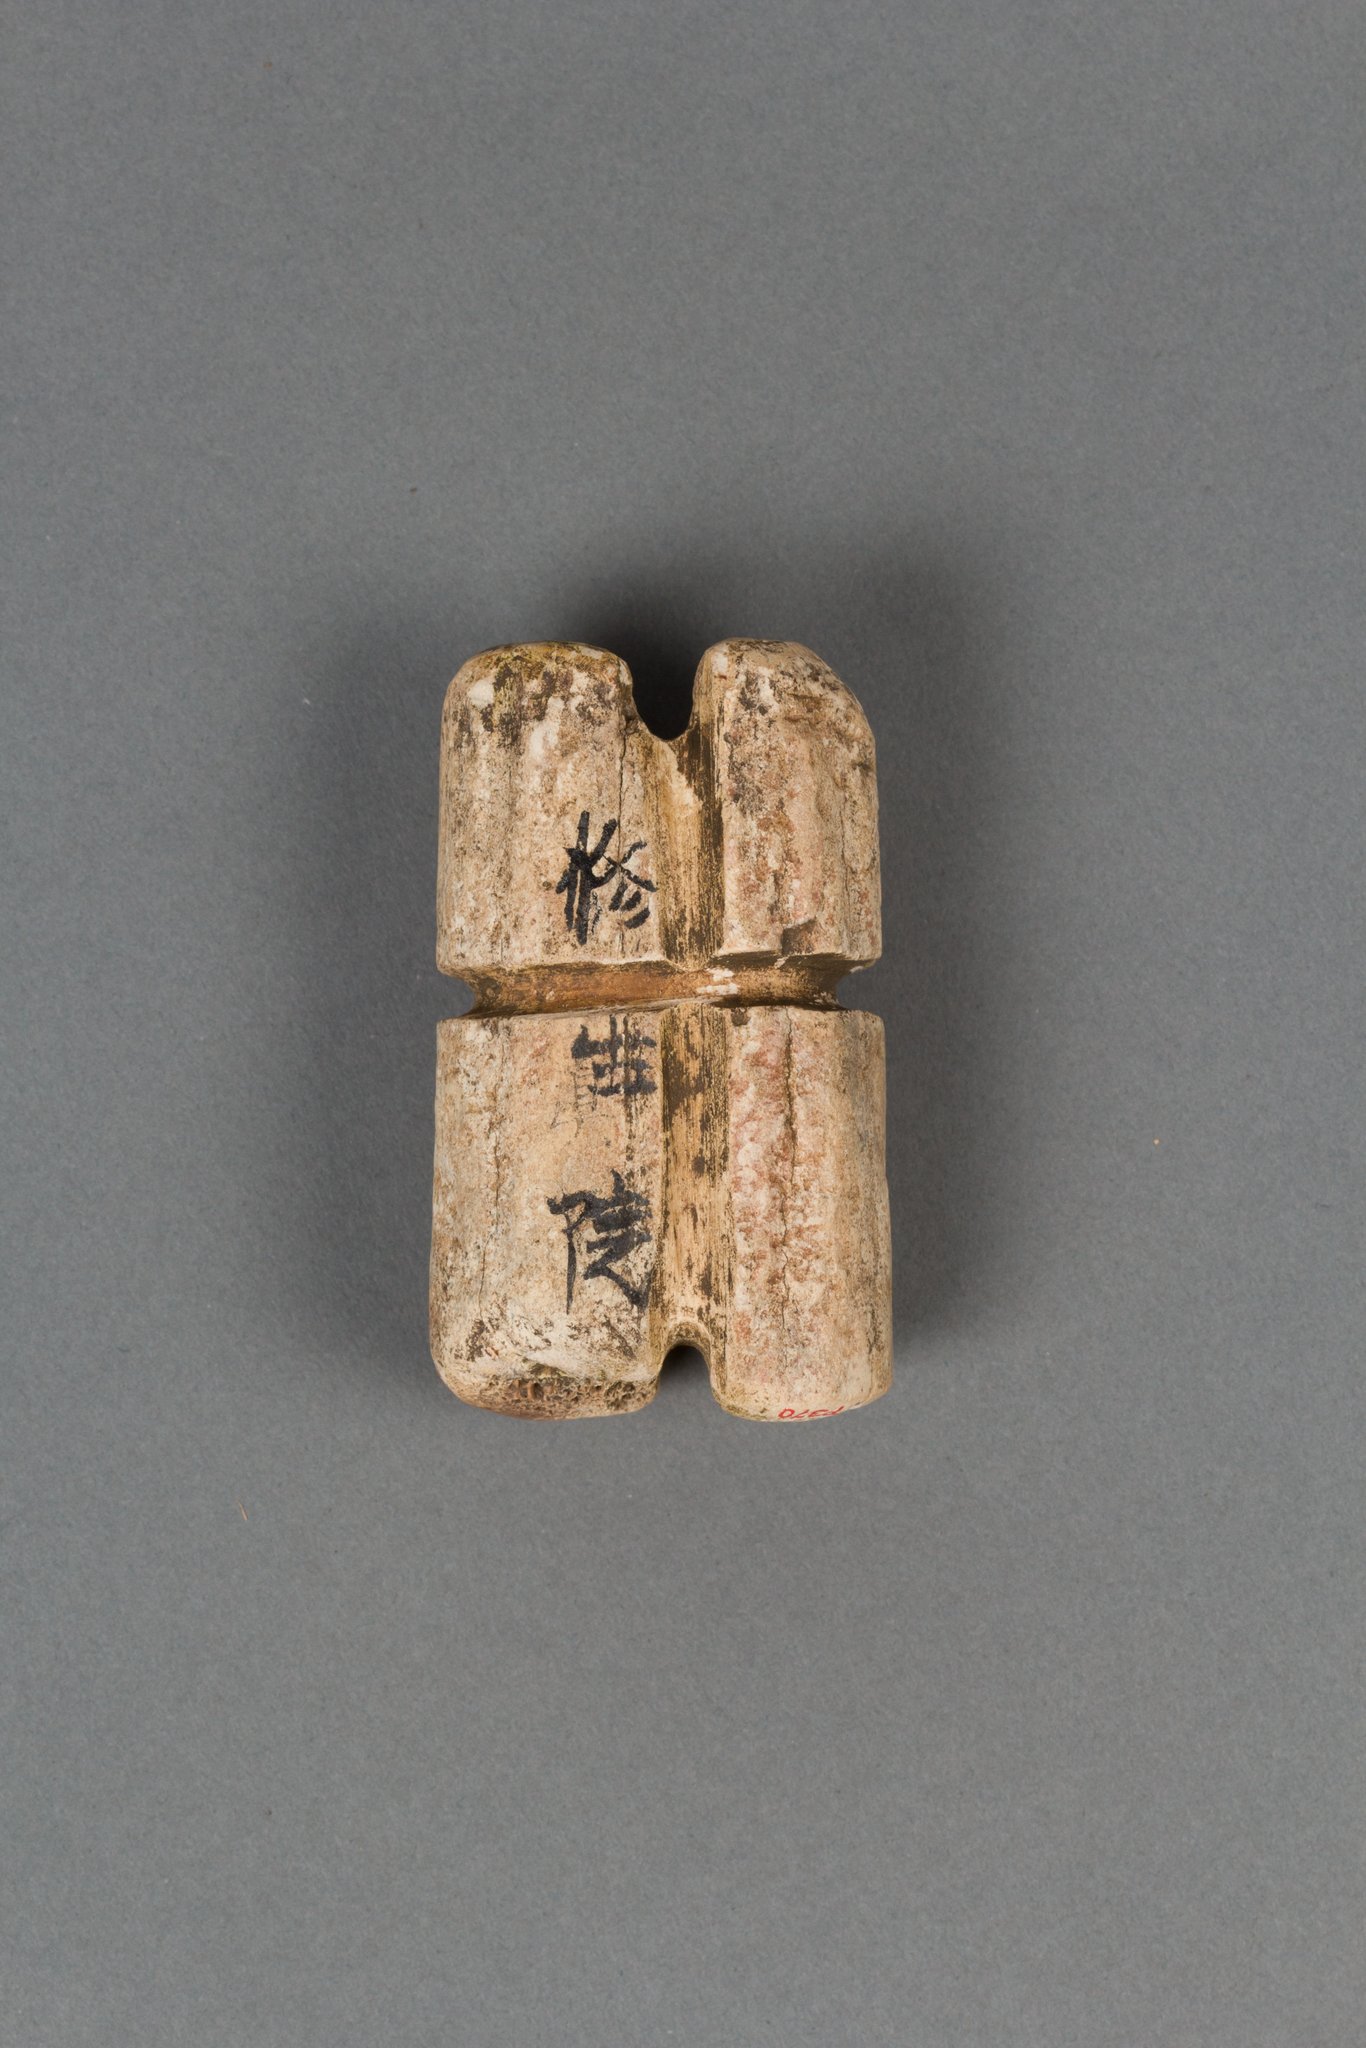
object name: fishnet sinker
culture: japanese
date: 1200-200 BCE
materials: bone